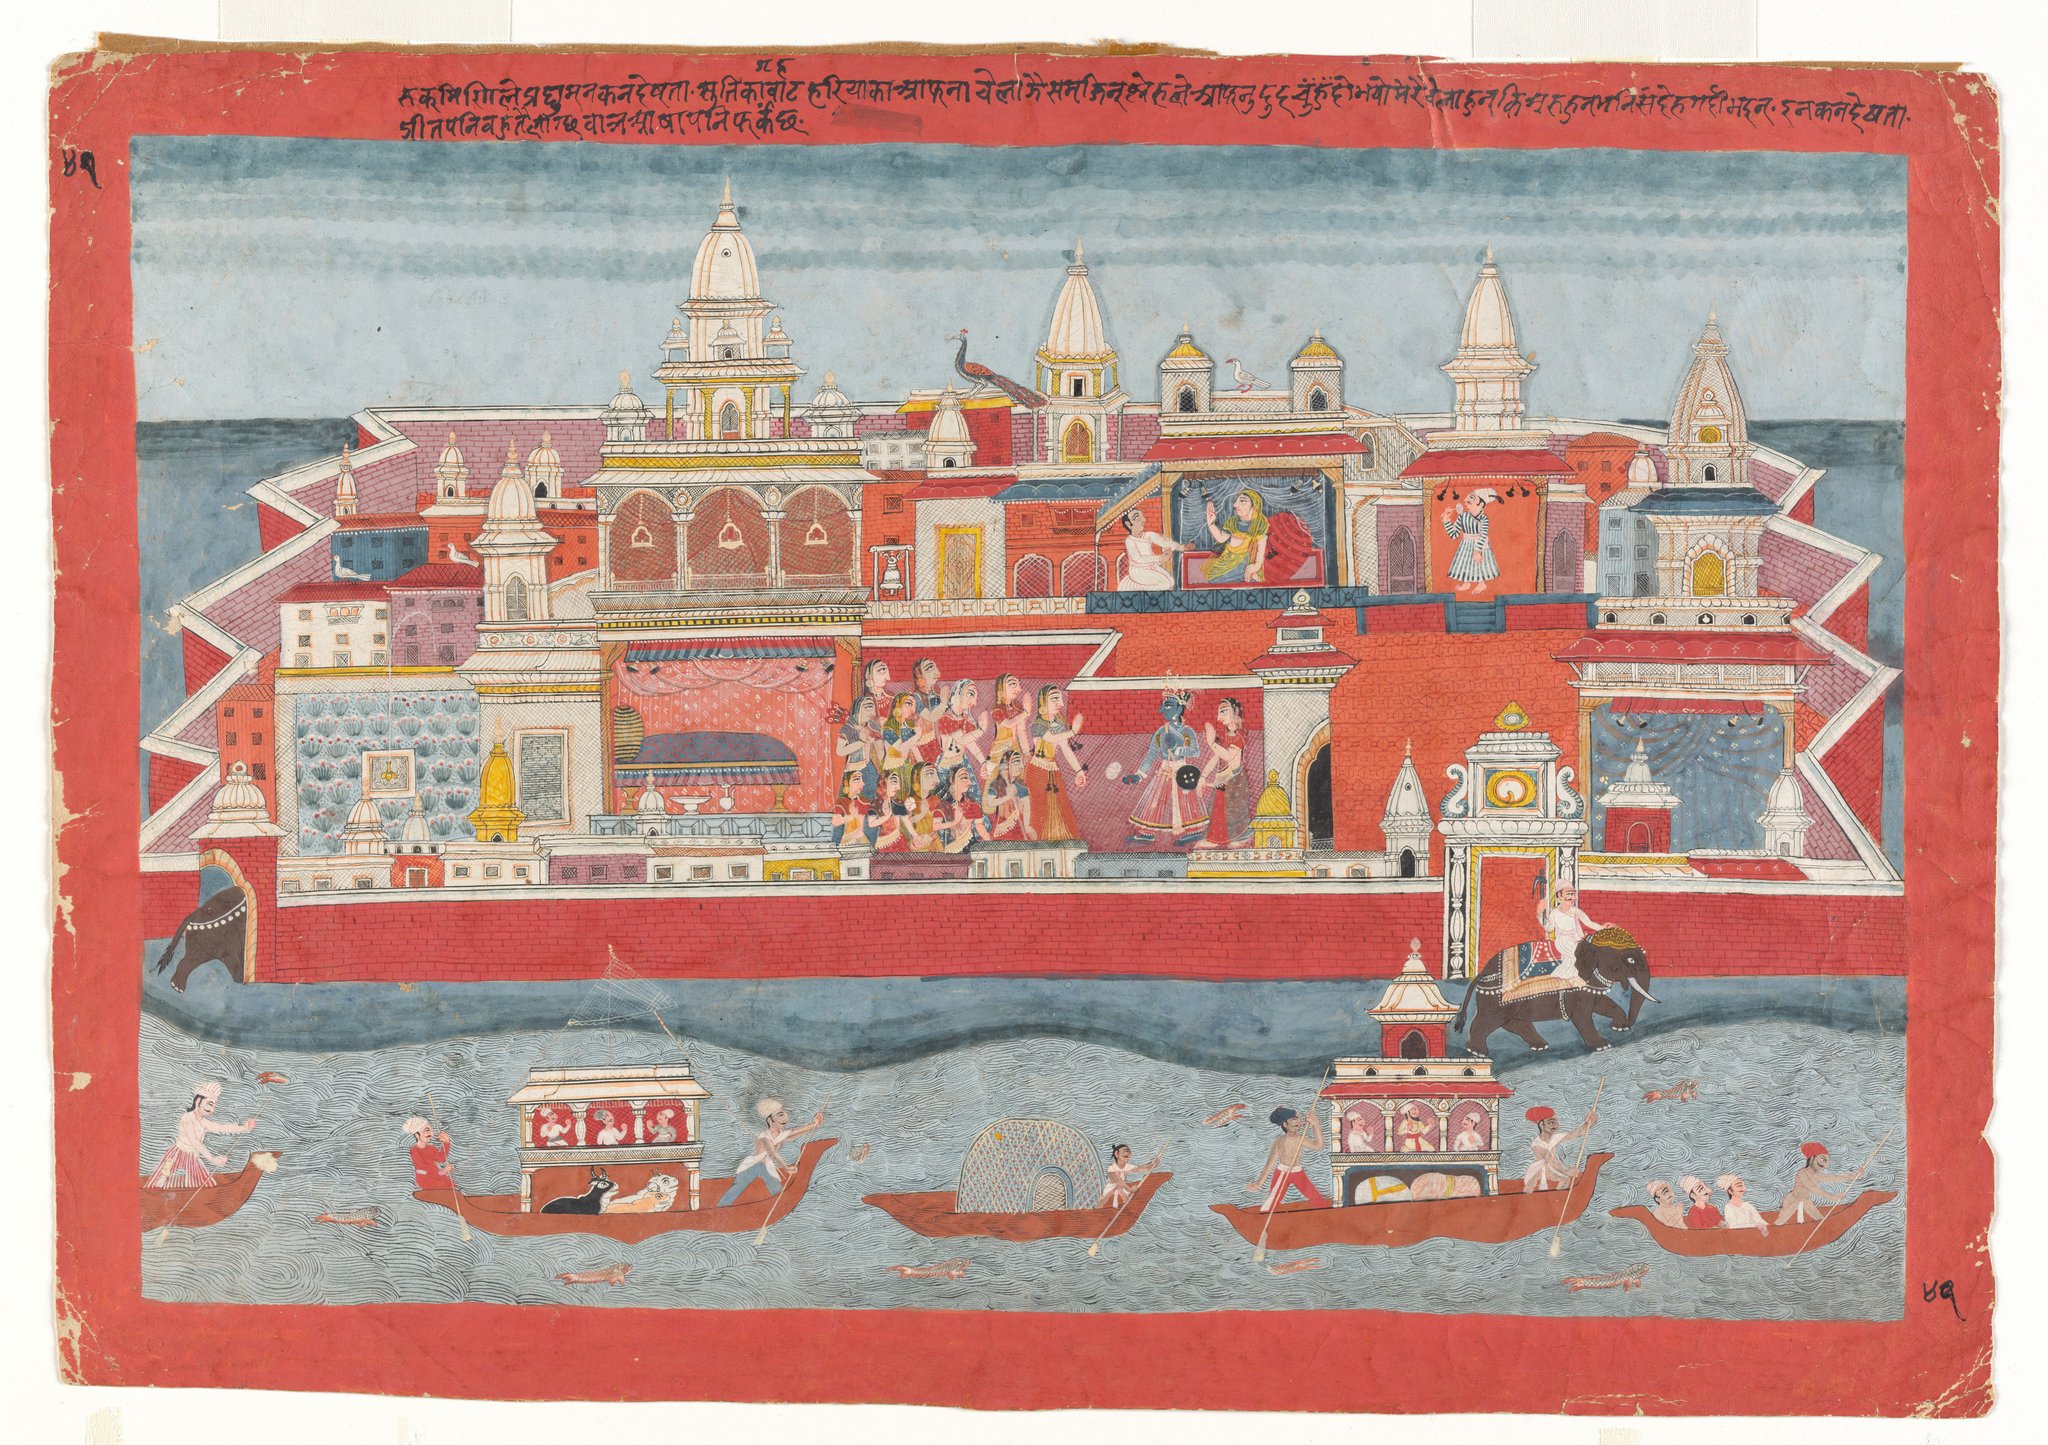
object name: folio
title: Folio from a Bhagavata Purana series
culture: nepali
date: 1775-1800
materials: ink, paper, watercolor